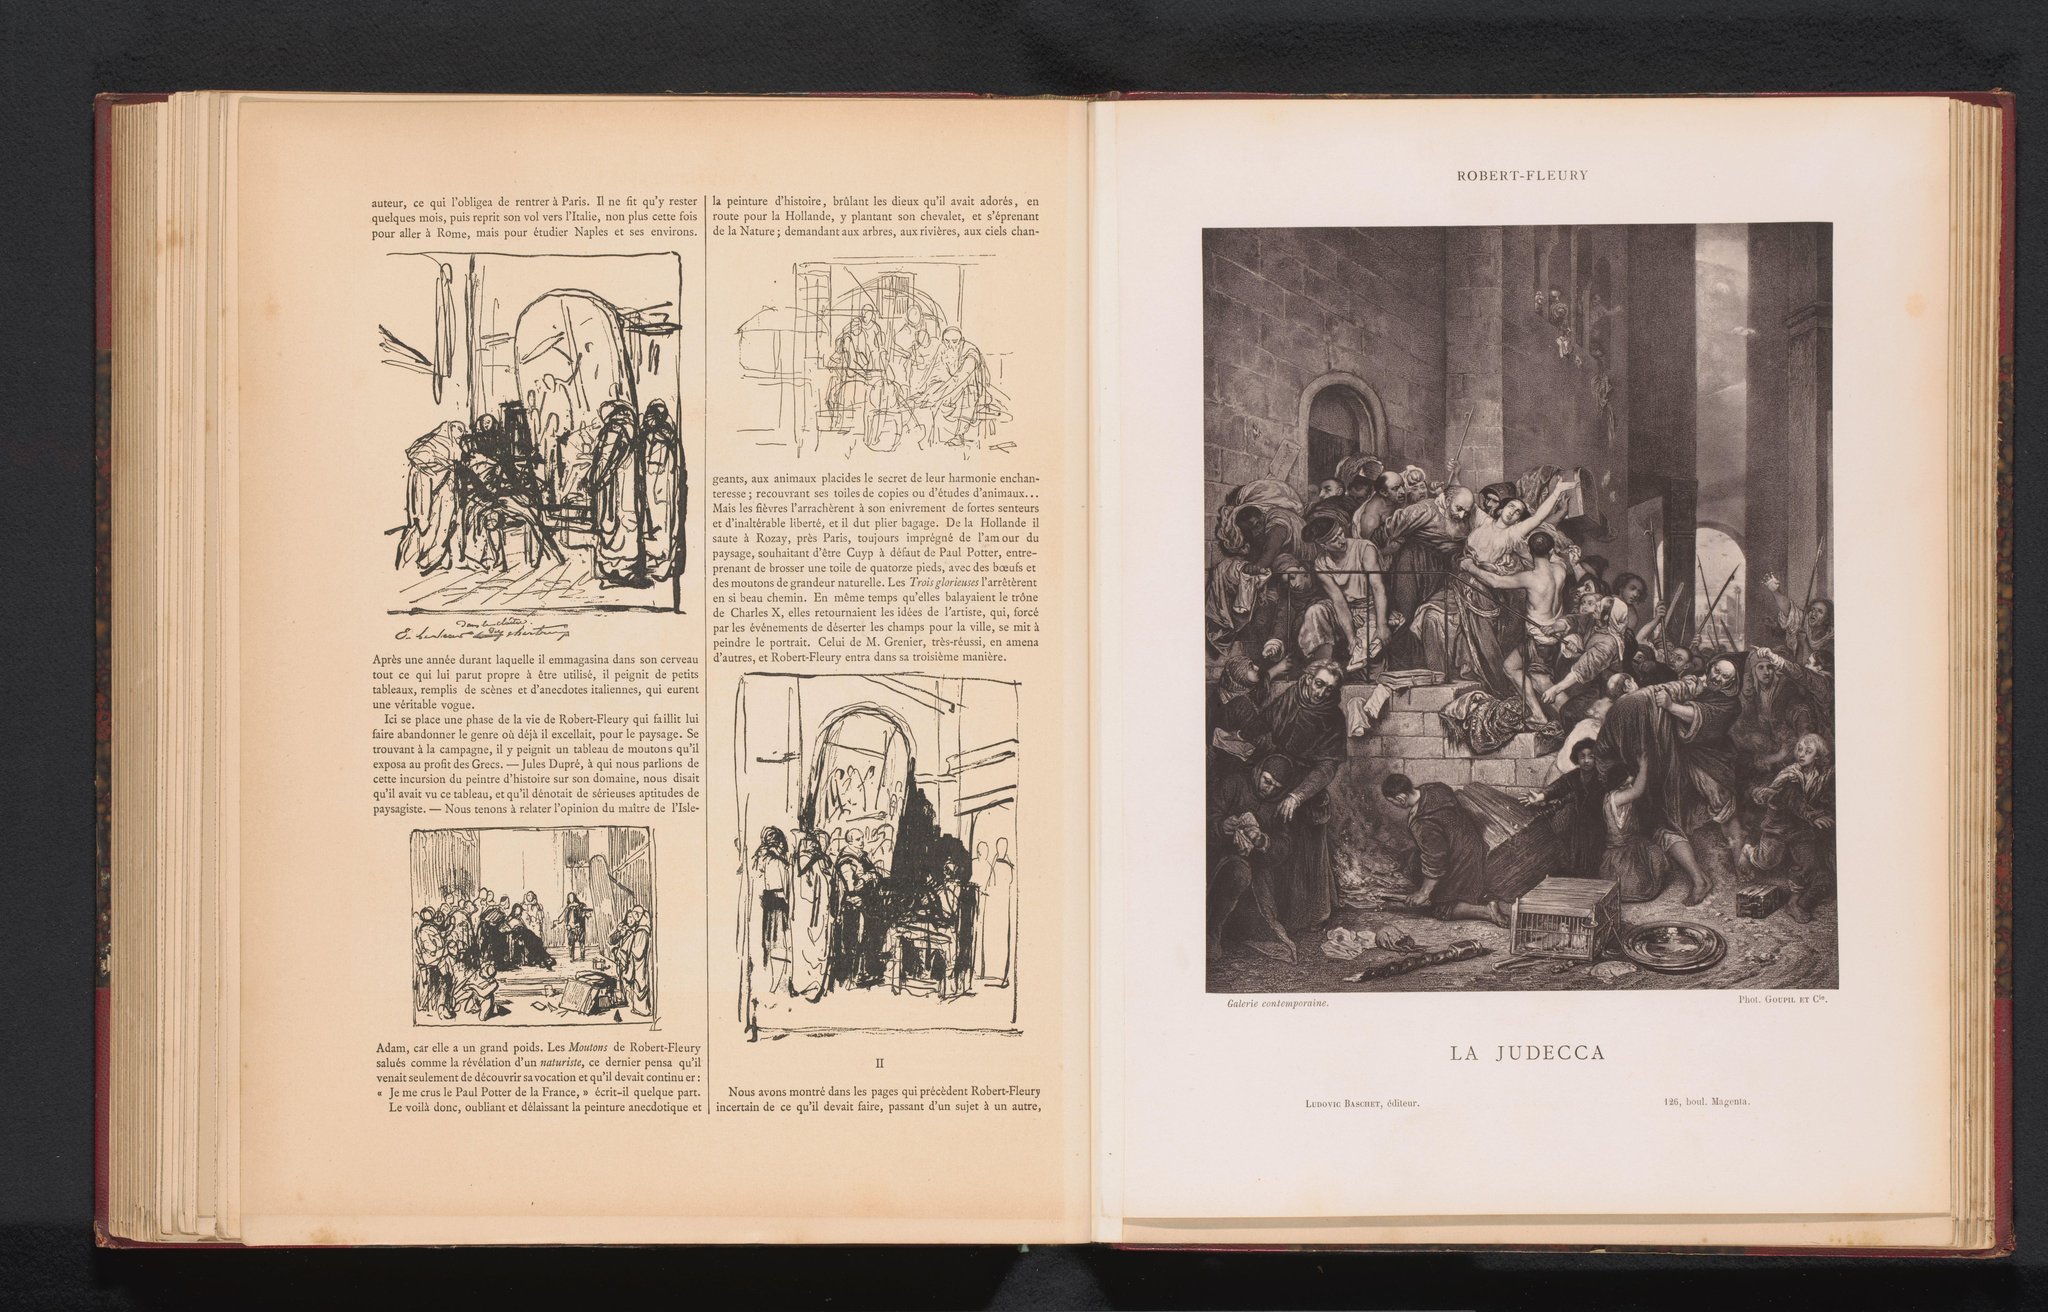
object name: reproduction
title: La Judecca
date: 1874-1879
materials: paper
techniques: woodburytype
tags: theft, painting, drawing and the graphic arts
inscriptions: inscription: ‘Galerie Contemporaine/ Ludovic Baschet, éditeur./ 126, boul. Magenta.’